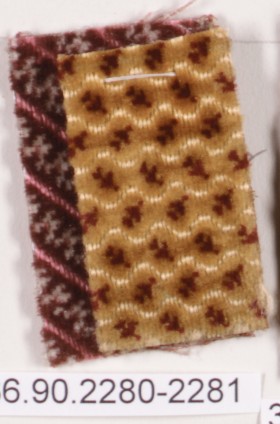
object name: piece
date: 1801-1900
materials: silk